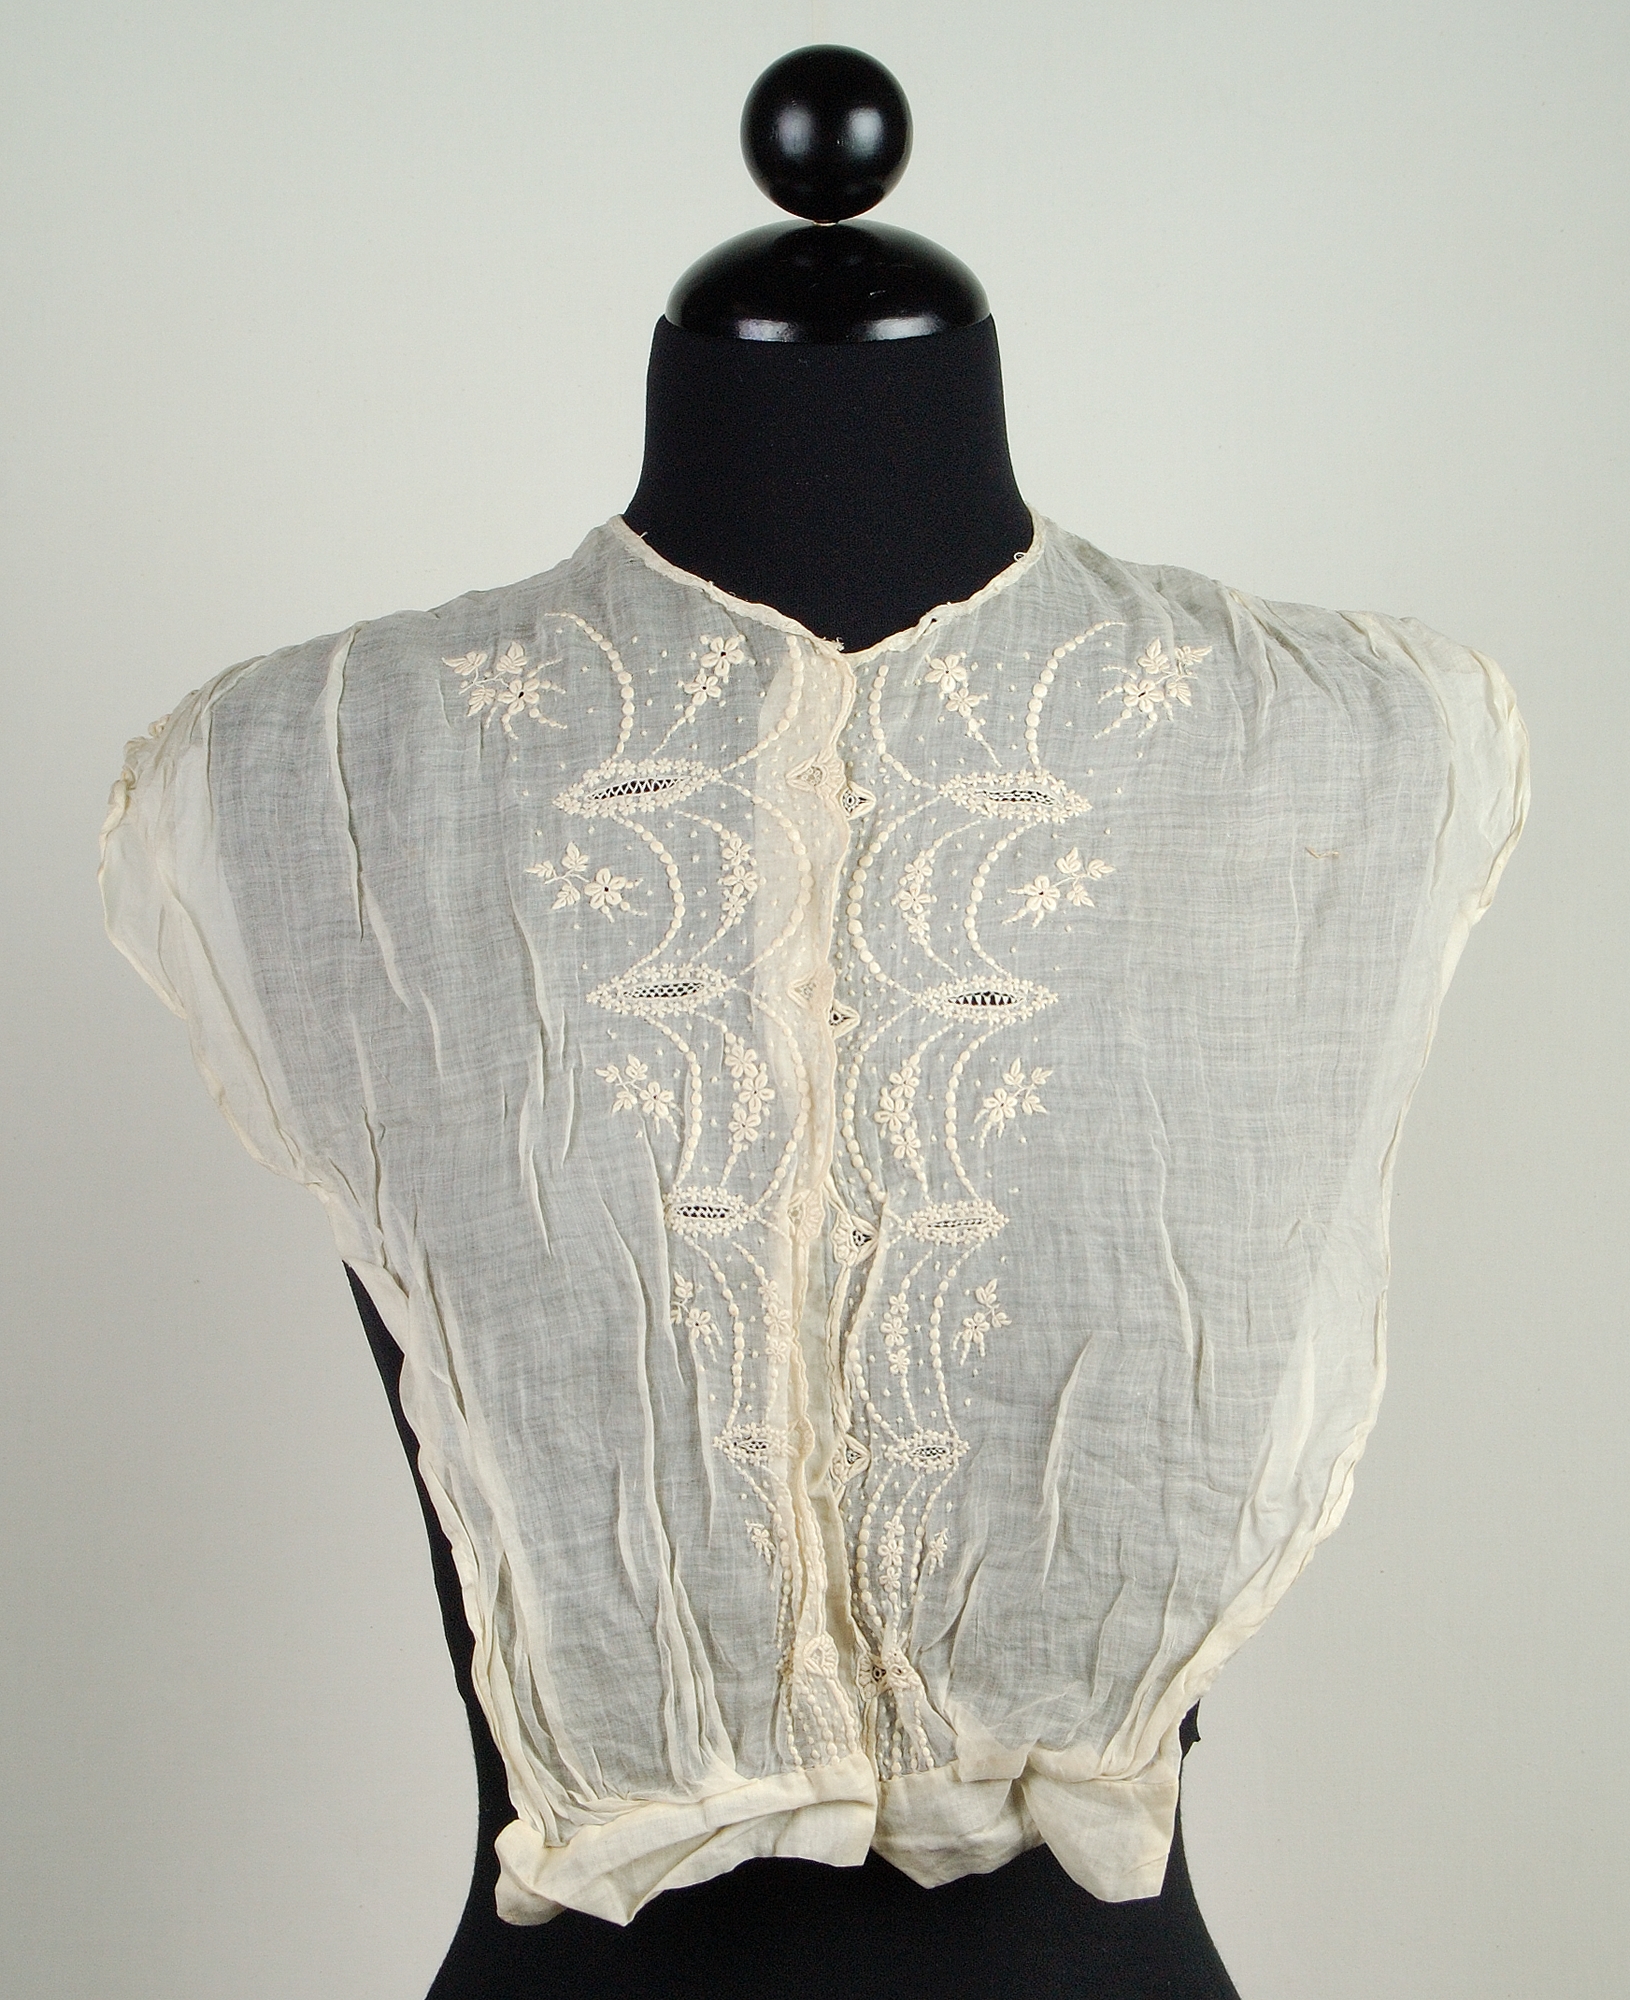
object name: chemise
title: Chemisette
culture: american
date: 1850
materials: cotton